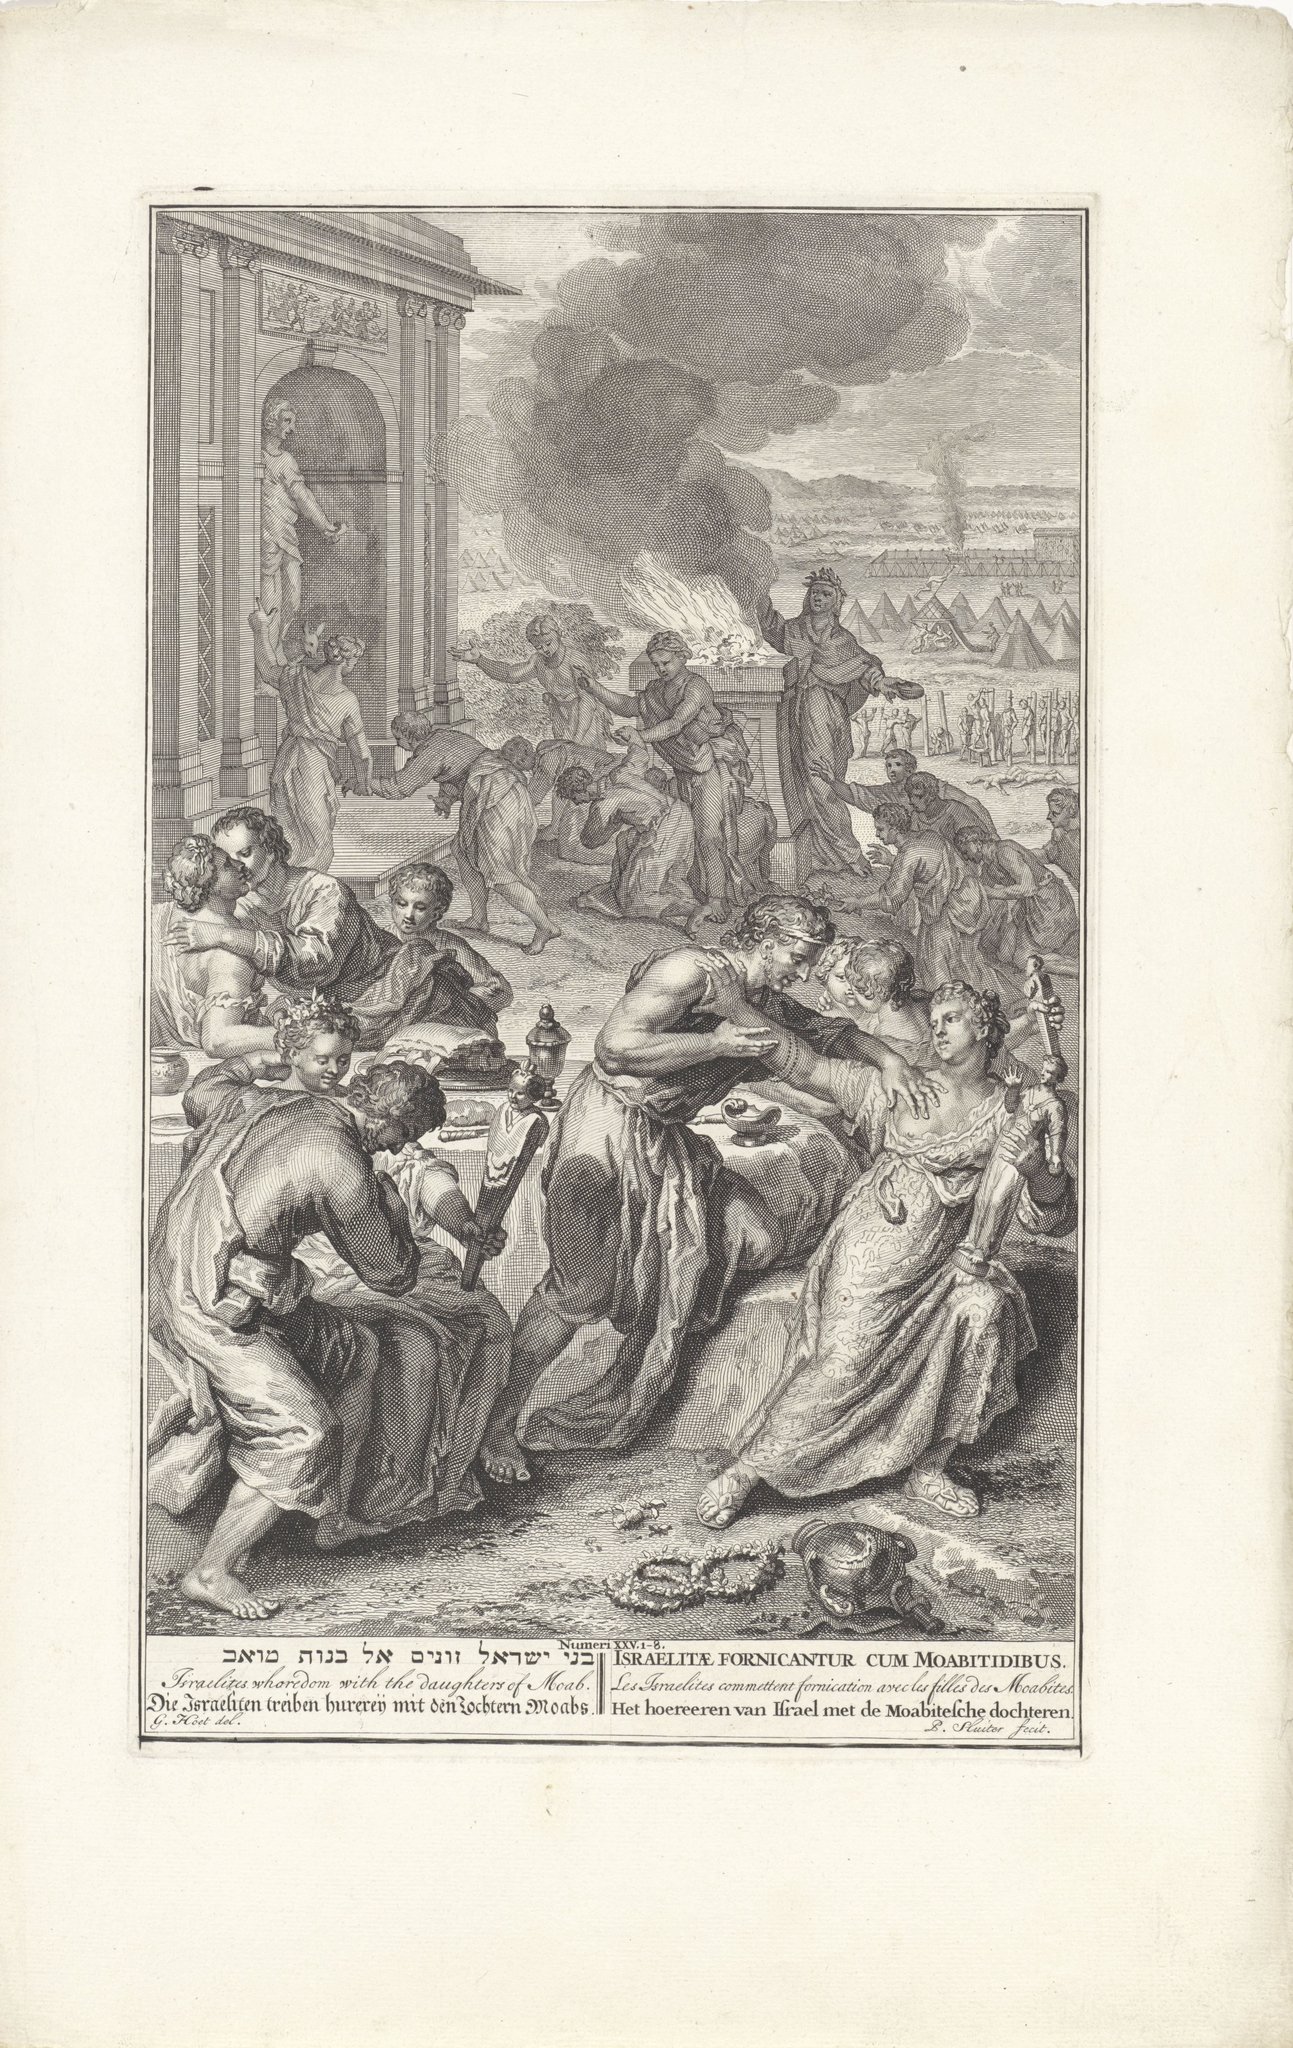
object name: print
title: Het hoereren van Israel met de Moabitesche dochteren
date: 1705-1720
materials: paper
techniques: etching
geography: amsterdam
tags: the israelites who had intercourse with the moabite women are punished, the moabite women lead the israelites into the worship of baal-peor, the israelites and the moabite women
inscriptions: collector's mark: Lugt 2228, collector's mark: ‘utrechts fundatie huijs’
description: Rond een rijk gedekte tafel vrijen de Israëlieten met de Moabitische vrouwen, die elk een afgodsbeeld in de hand houden. Daarachter buigen Israëlieten voor een afgodsbeeld in een tempel, daartoe aangezet door de heidense vrouwen. In een tentenkamp op de achtergrond is te zien hoe Pinechas, de zoon van Eleazar, een Israëliet en een Moabitische vrouw met een speer vermoordt. Daarvoor is te zien hoe de mannen van Israel opgeknoopt worden aan palen. Illustratie van de Bijbeltekst Num. 25:1-8. Onder de voorstelling de titel in het Hebreeuws, Engels, Duits, Latijn, Frans en Nederlands.